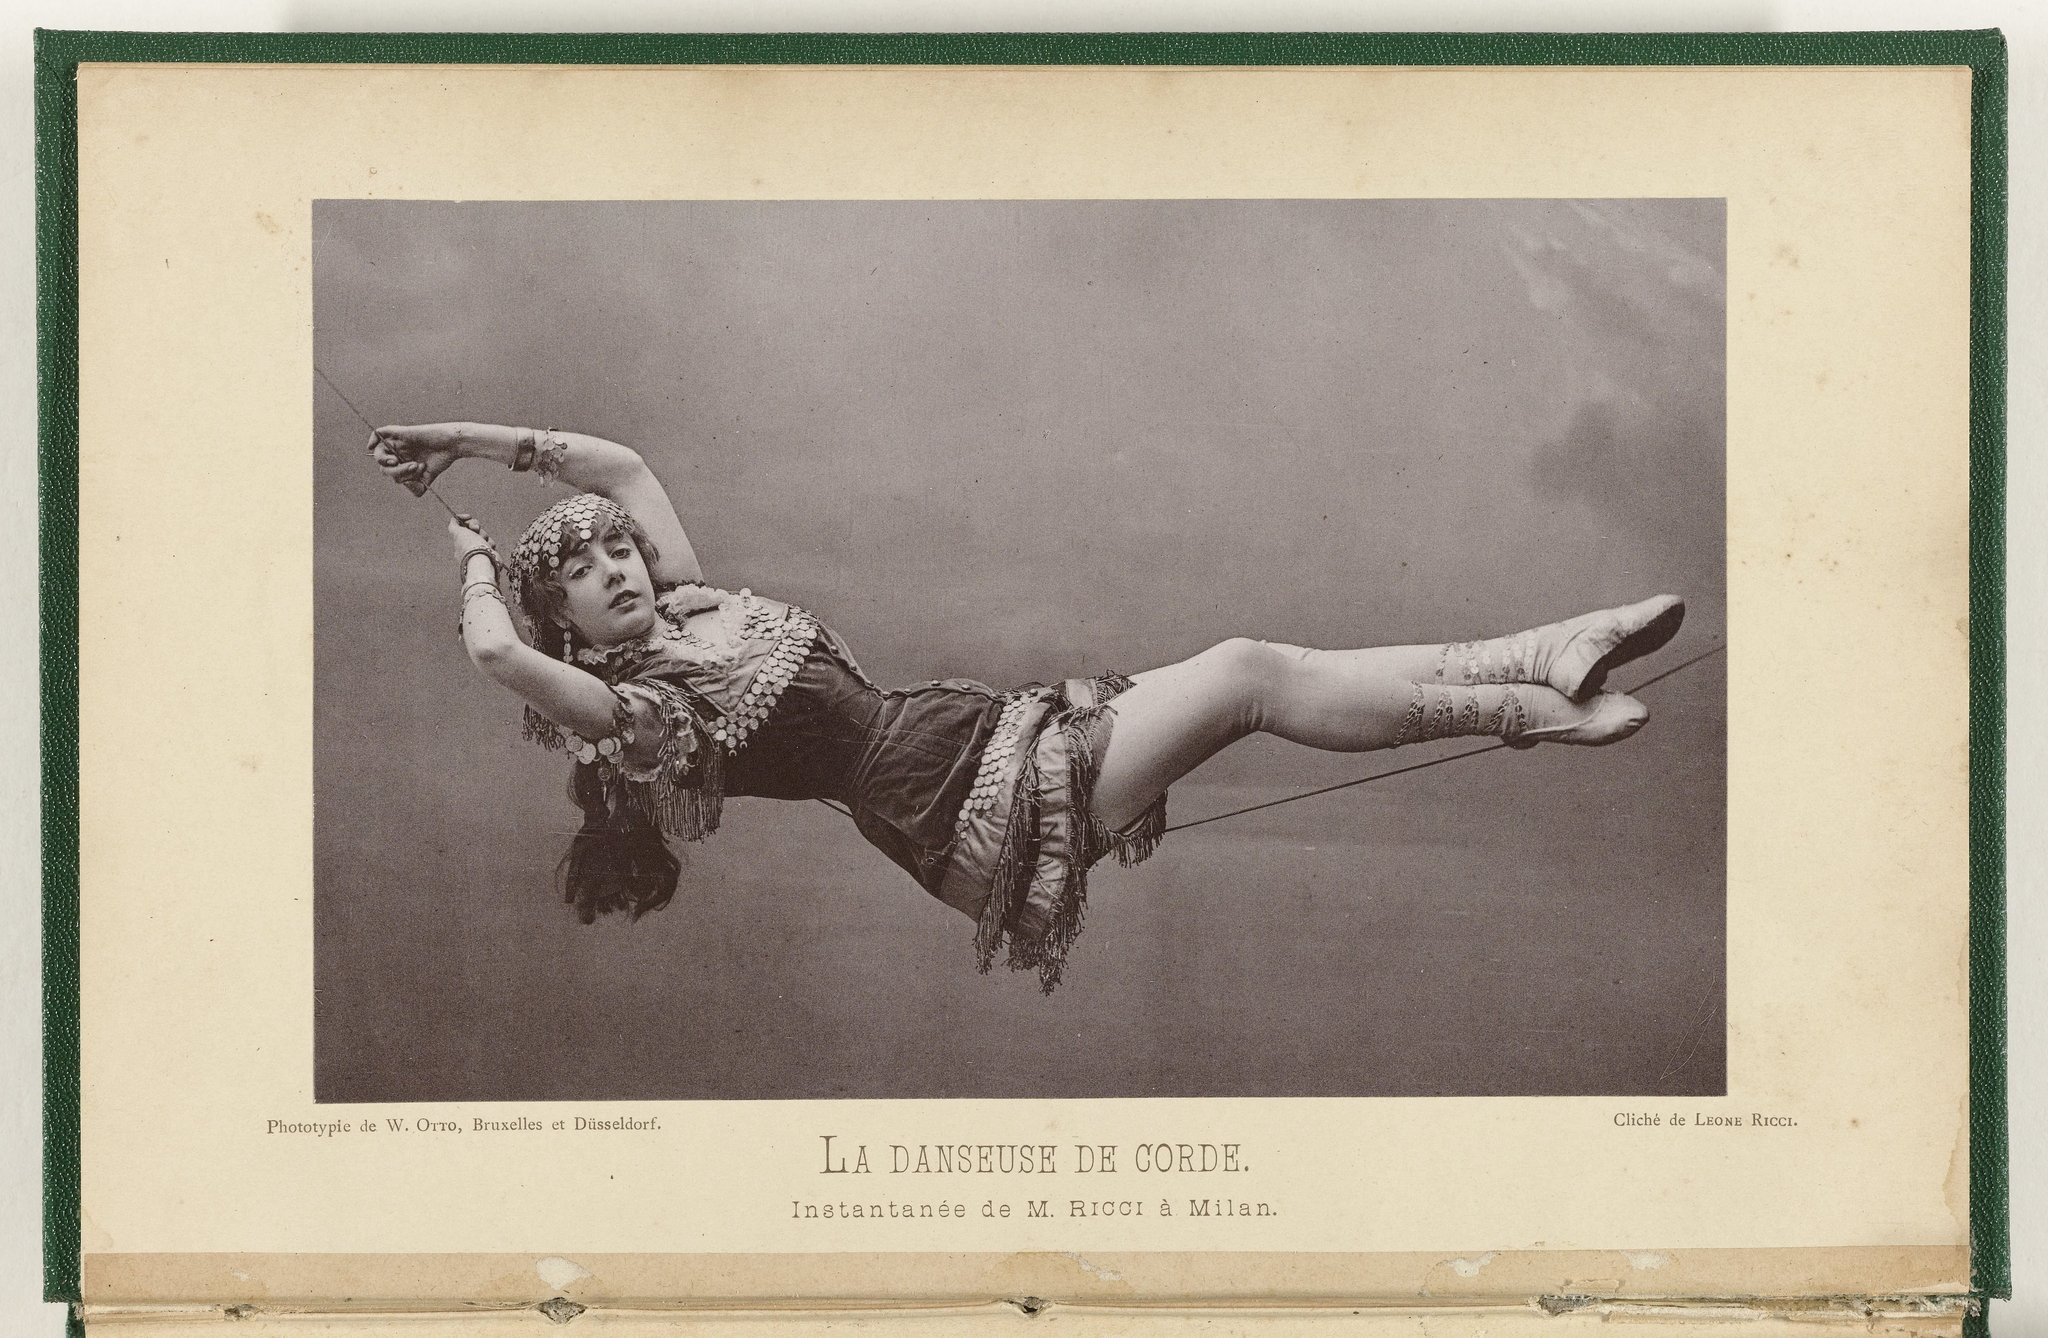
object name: photomechanical print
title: La danseuse de corde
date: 1880-1888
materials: paper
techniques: photograph